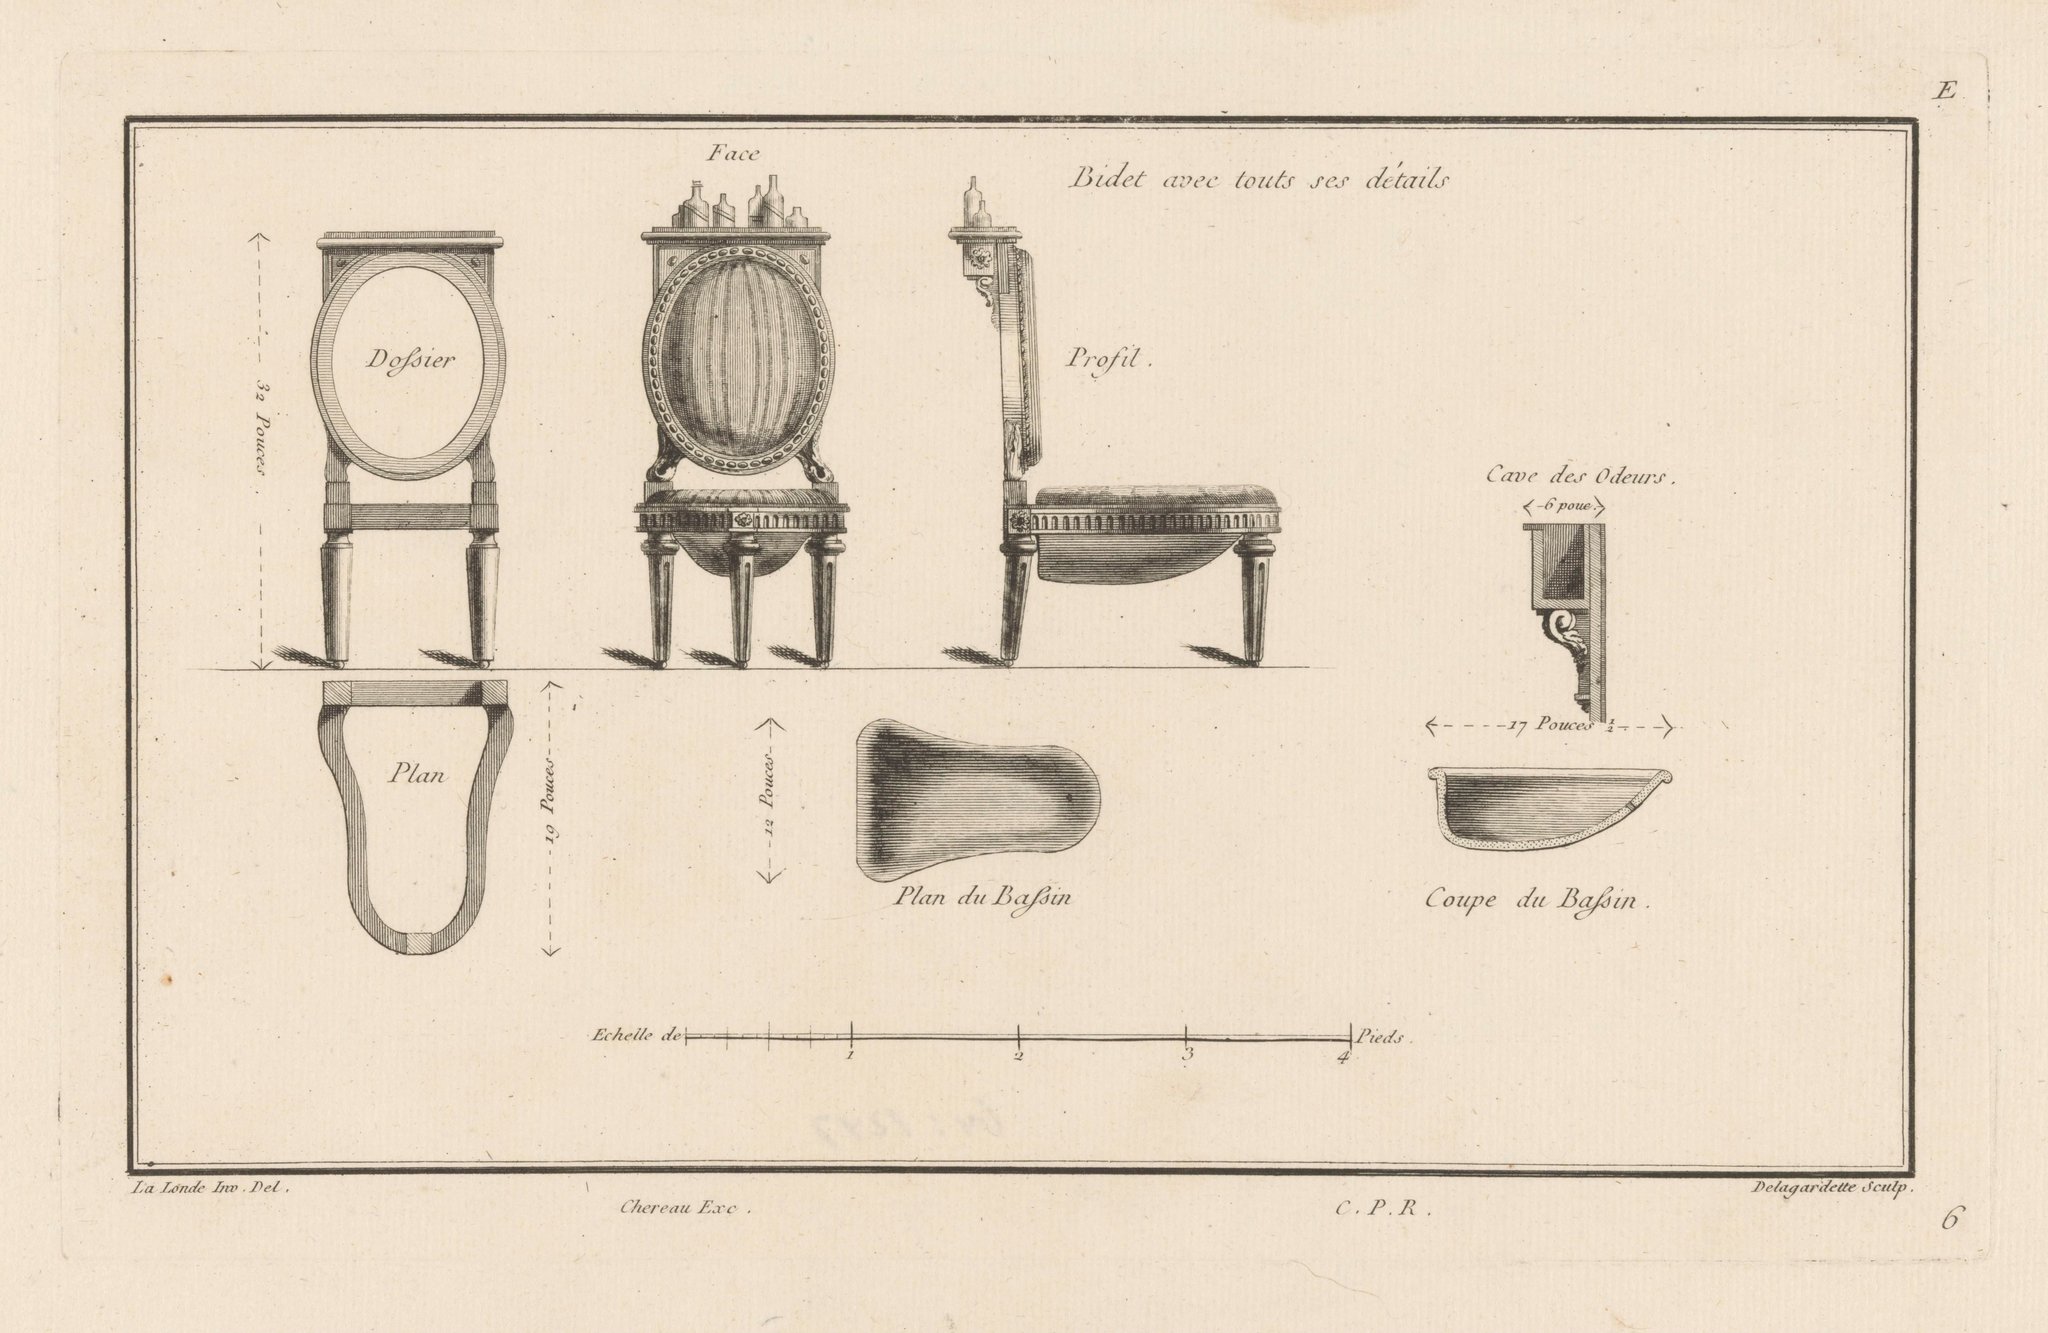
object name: print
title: Bidet avec touts ses détails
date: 1784-1785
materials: paper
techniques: etching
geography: paris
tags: bidet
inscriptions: collector's mark: Lugt 2228, collector's mark: Lugt 2760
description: Profiel, achter-, voor- en bovenaanzicht van een bidet en bovenaanzicht en doorsnede van het bassin.